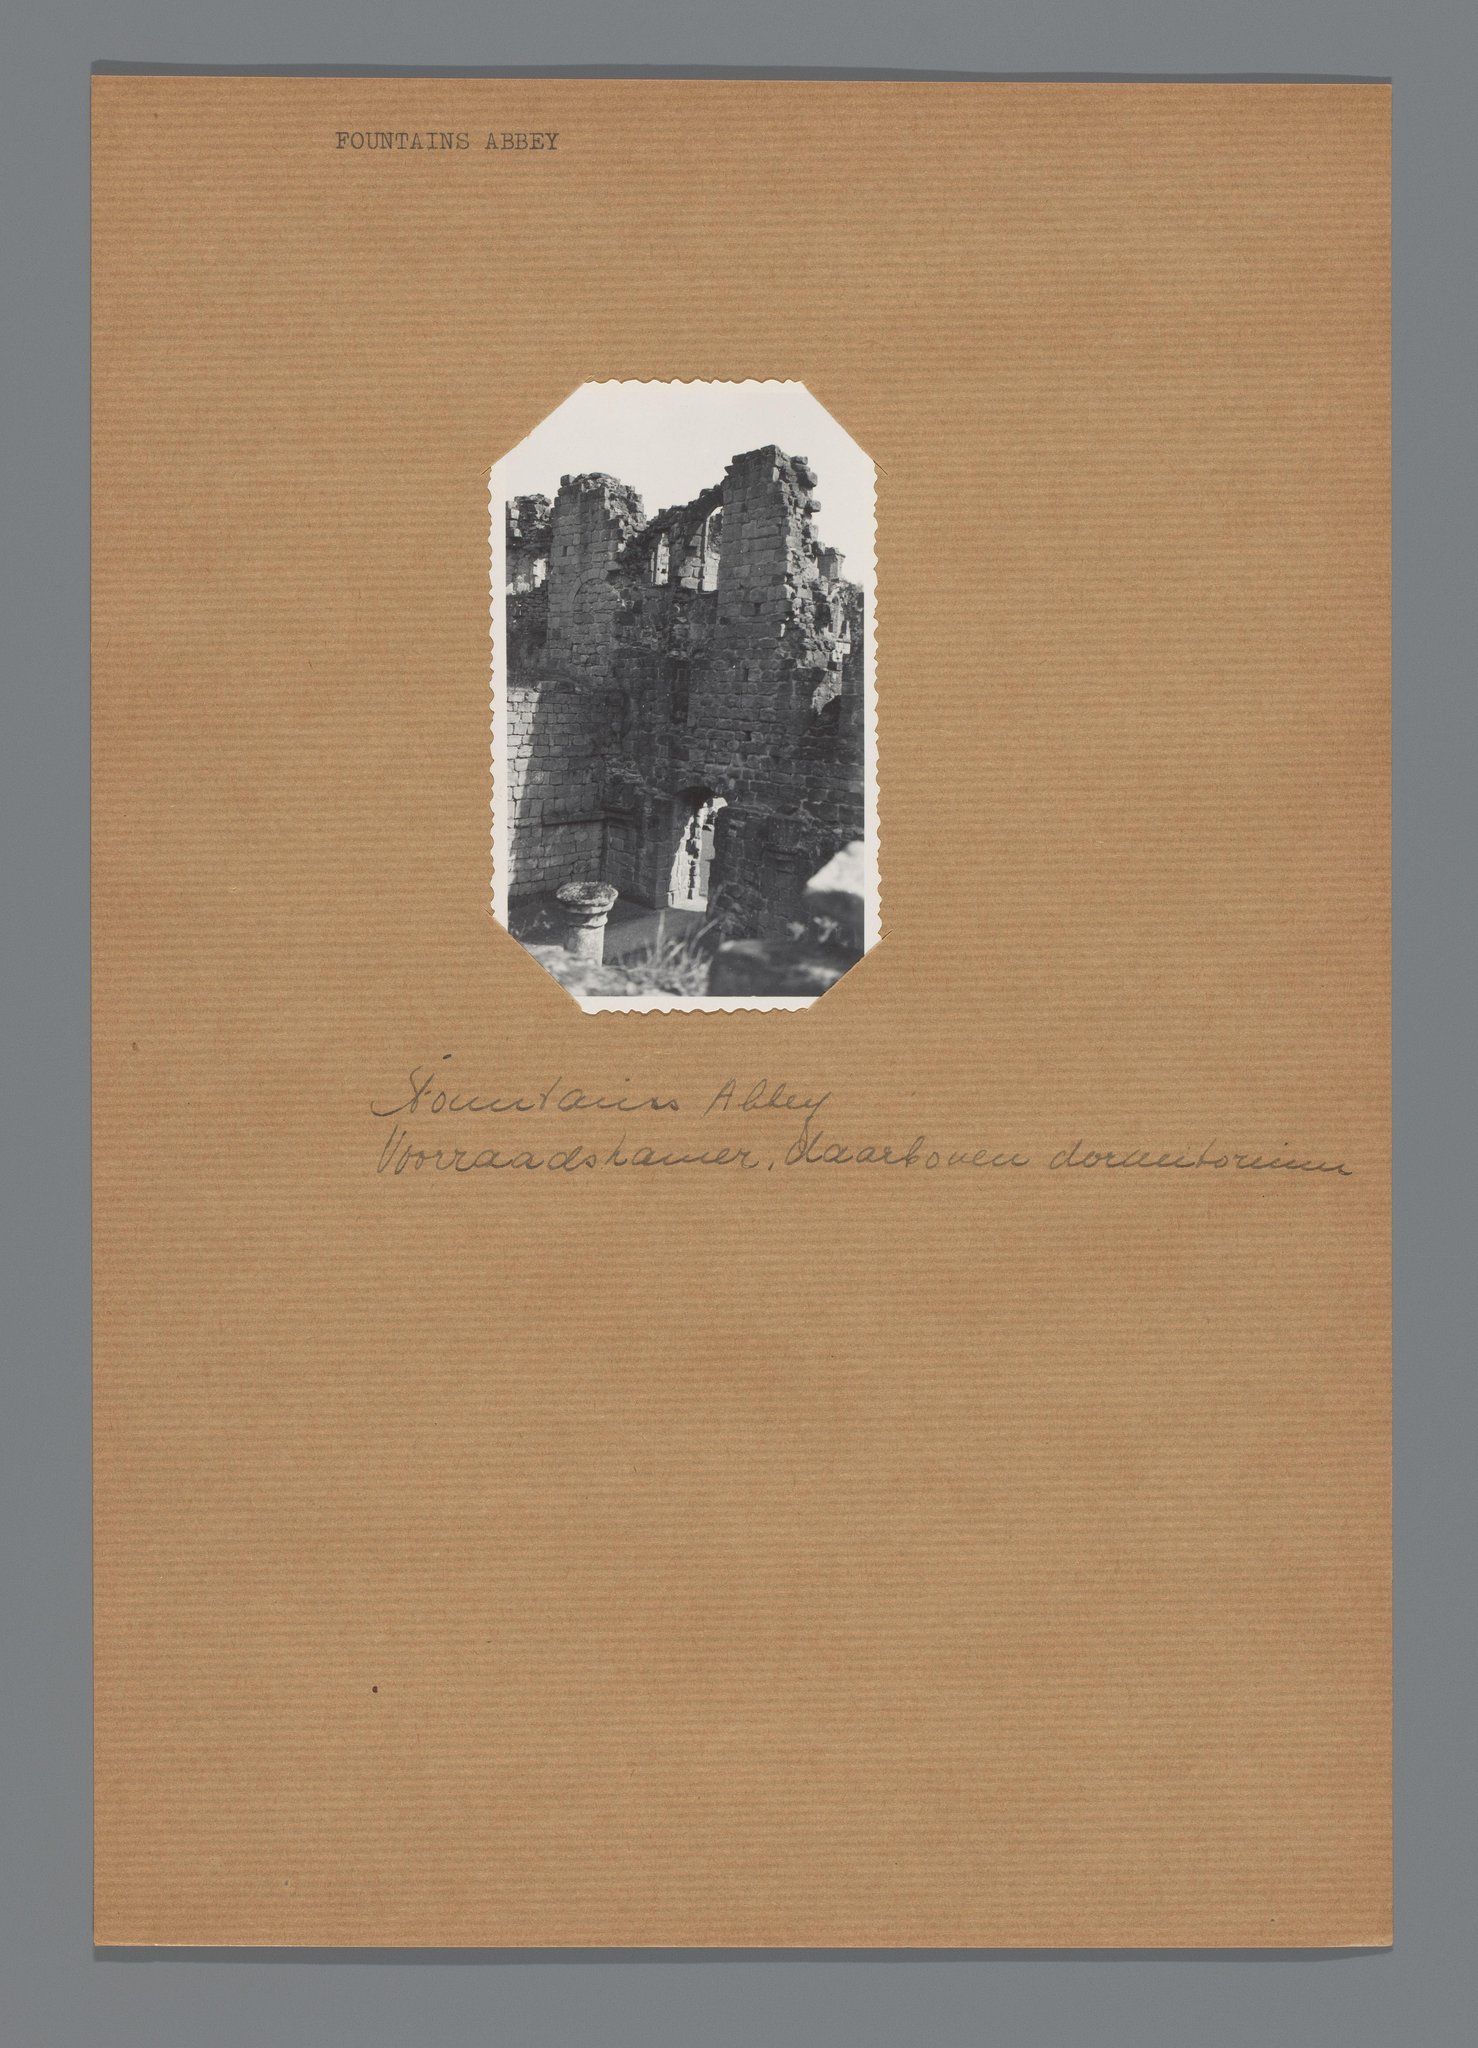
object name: photograph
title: England. Fountains Abbey.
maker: Anonymous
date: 1880-1920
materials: photographic support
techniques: gelatin silver print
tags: fountains abbey